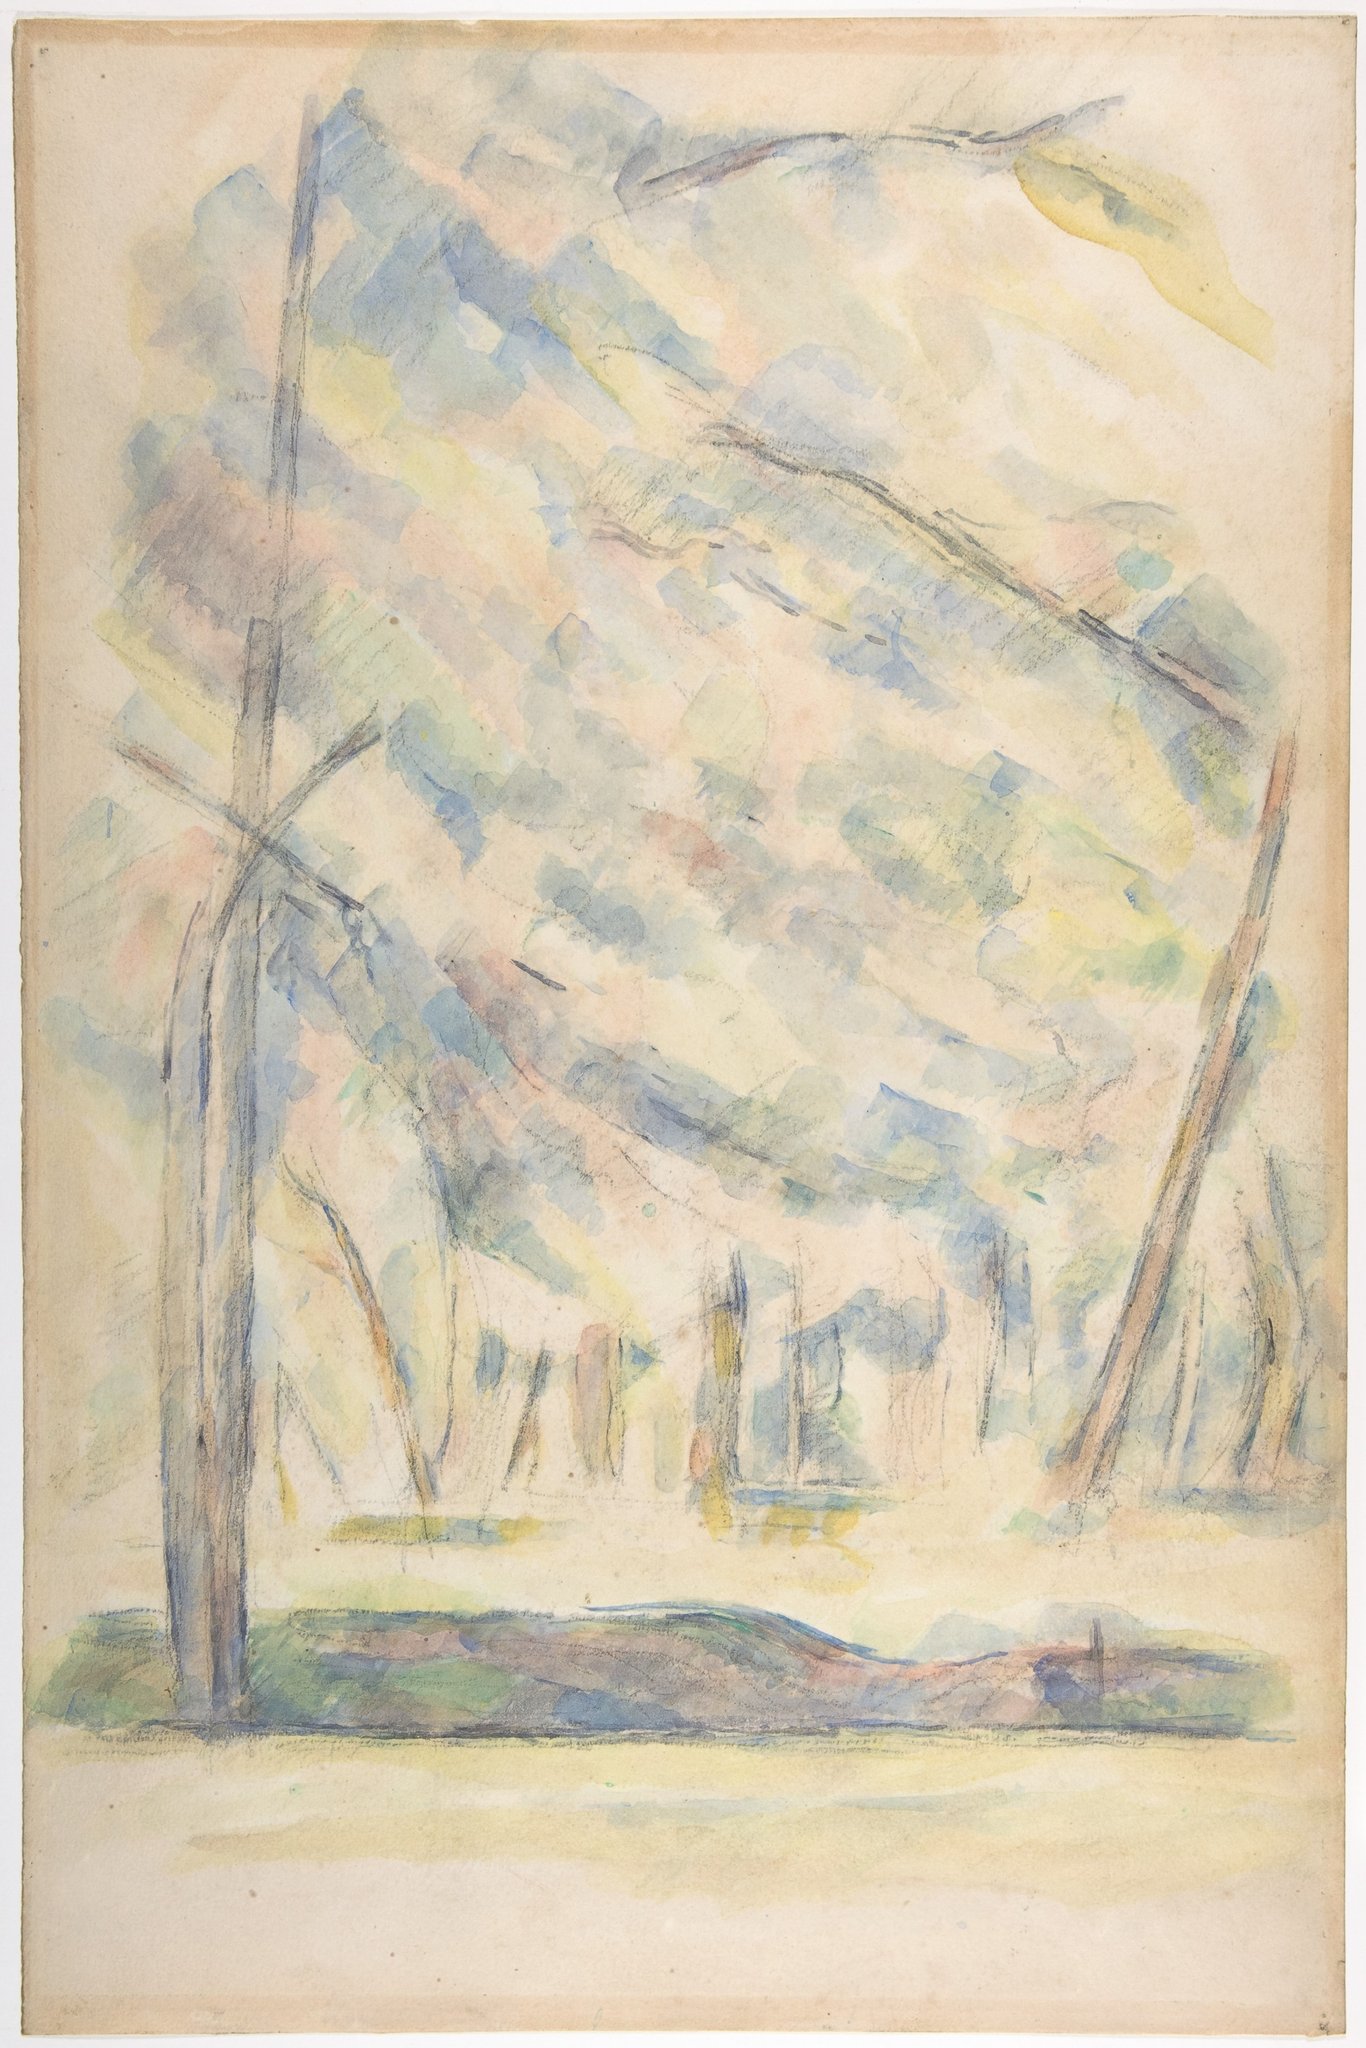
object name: drawing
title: Landscape (recto); Sketch of rocks(?) (verso)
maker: paul cézanne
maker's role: artist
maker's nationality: french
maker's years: 1839-1906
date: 1890-1895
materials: chalk, watercolor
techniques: wash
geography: france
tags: landscapes,trees